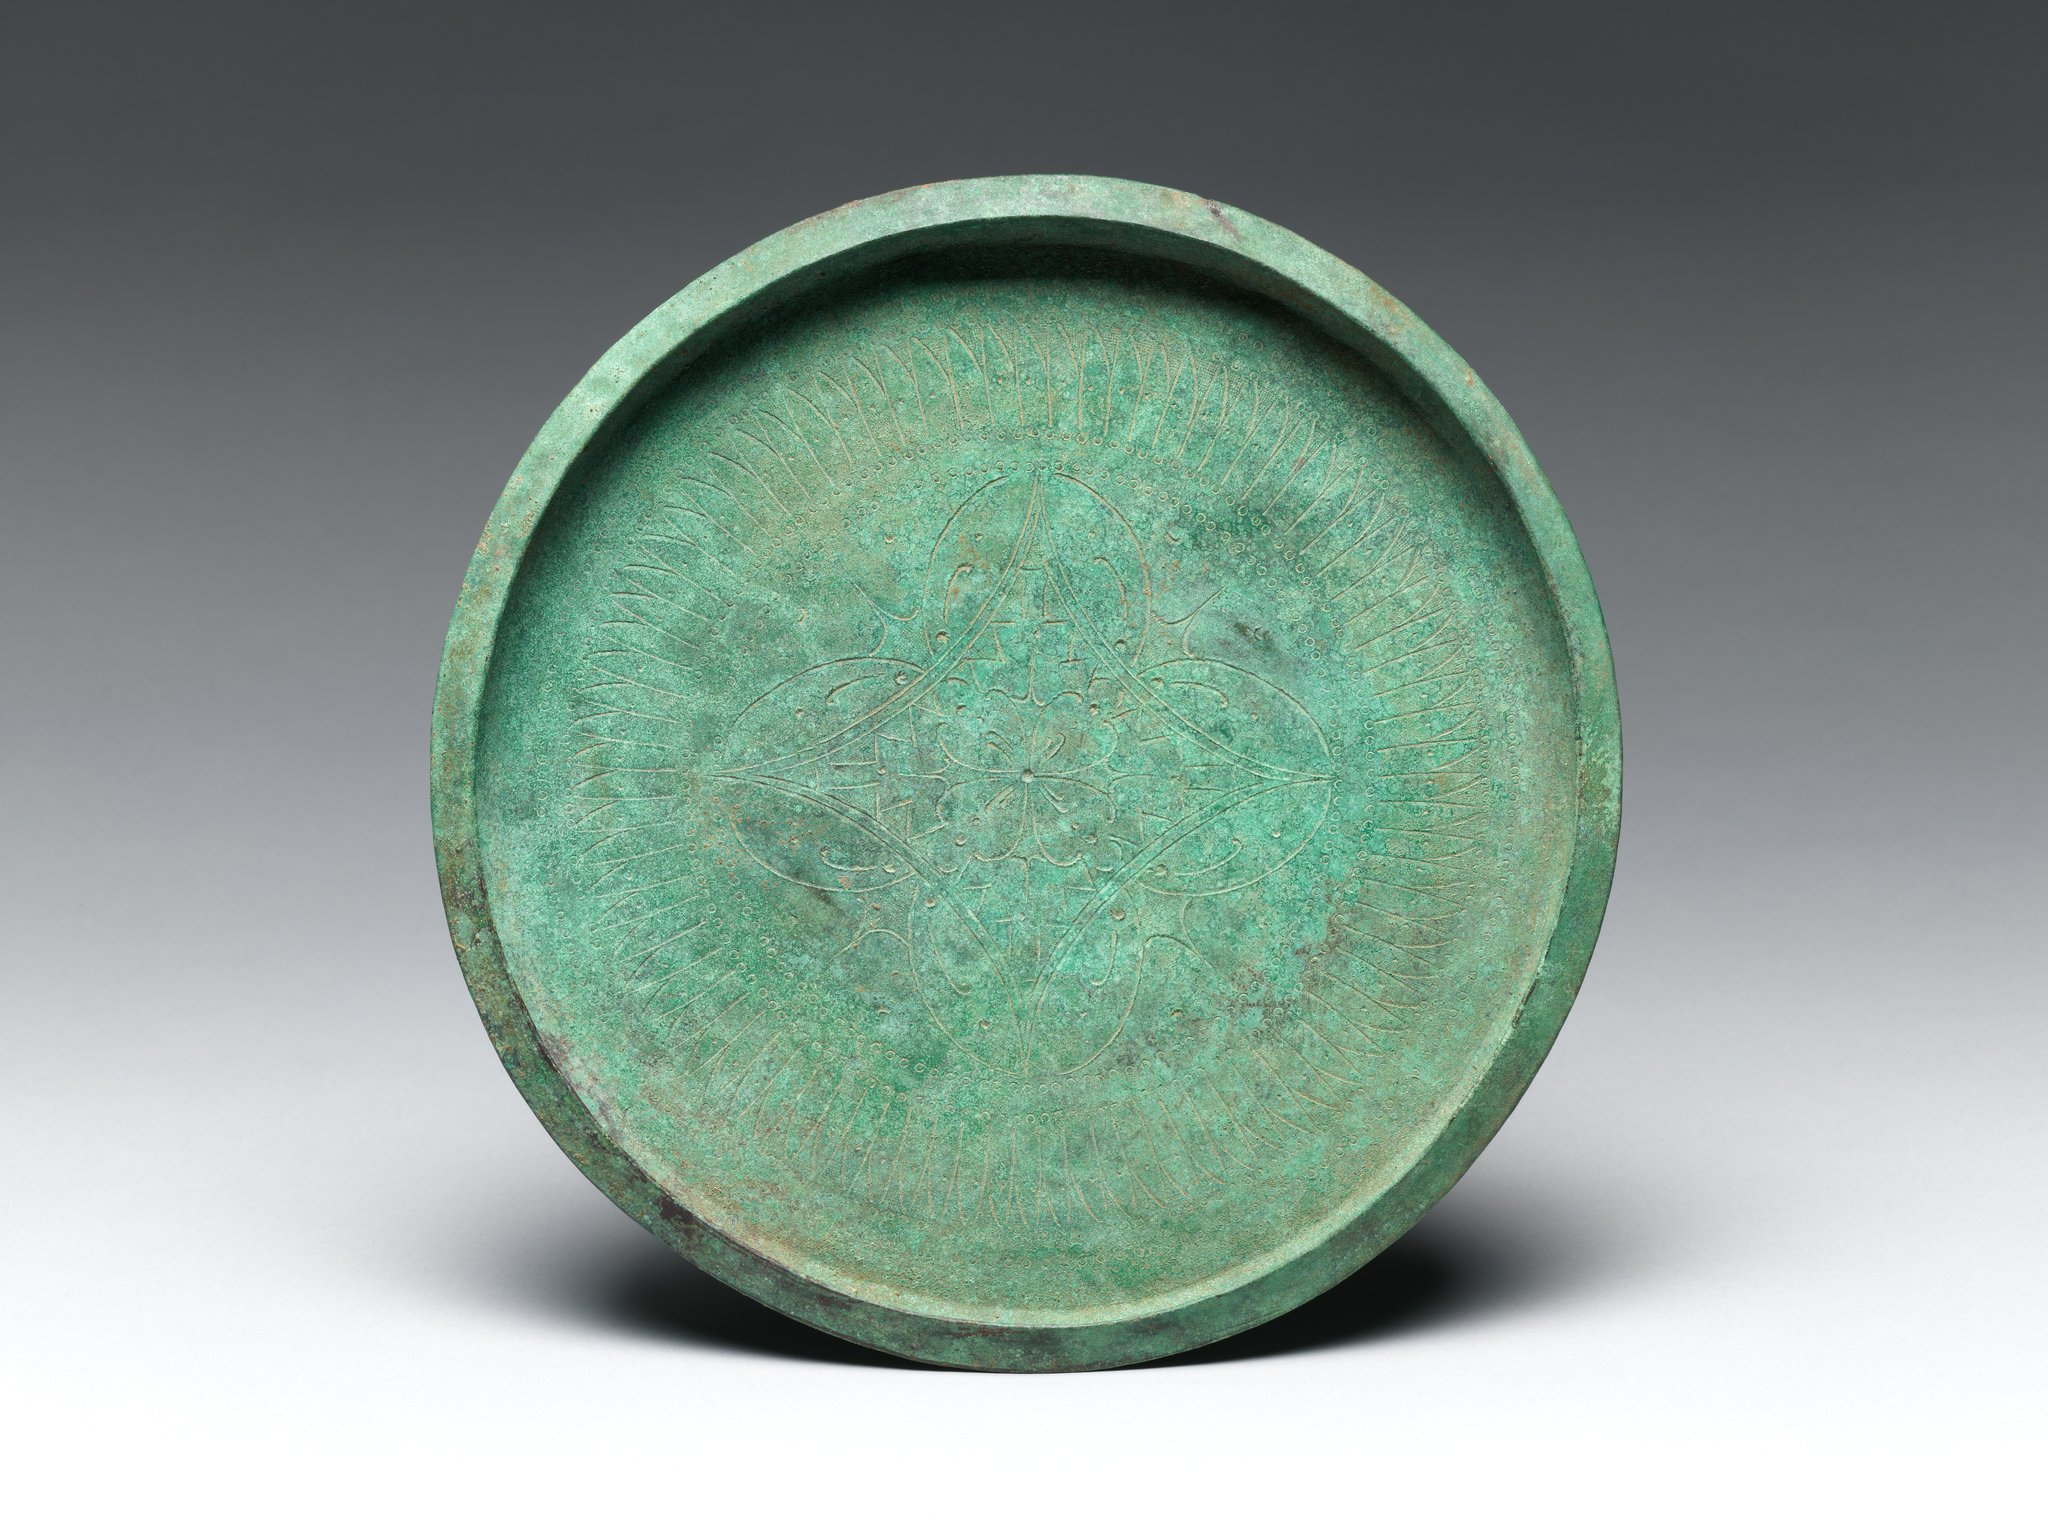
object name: offering tray talam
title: Offering Tray (Talam)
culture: indonesian, javanese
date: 901-1100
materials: bronze